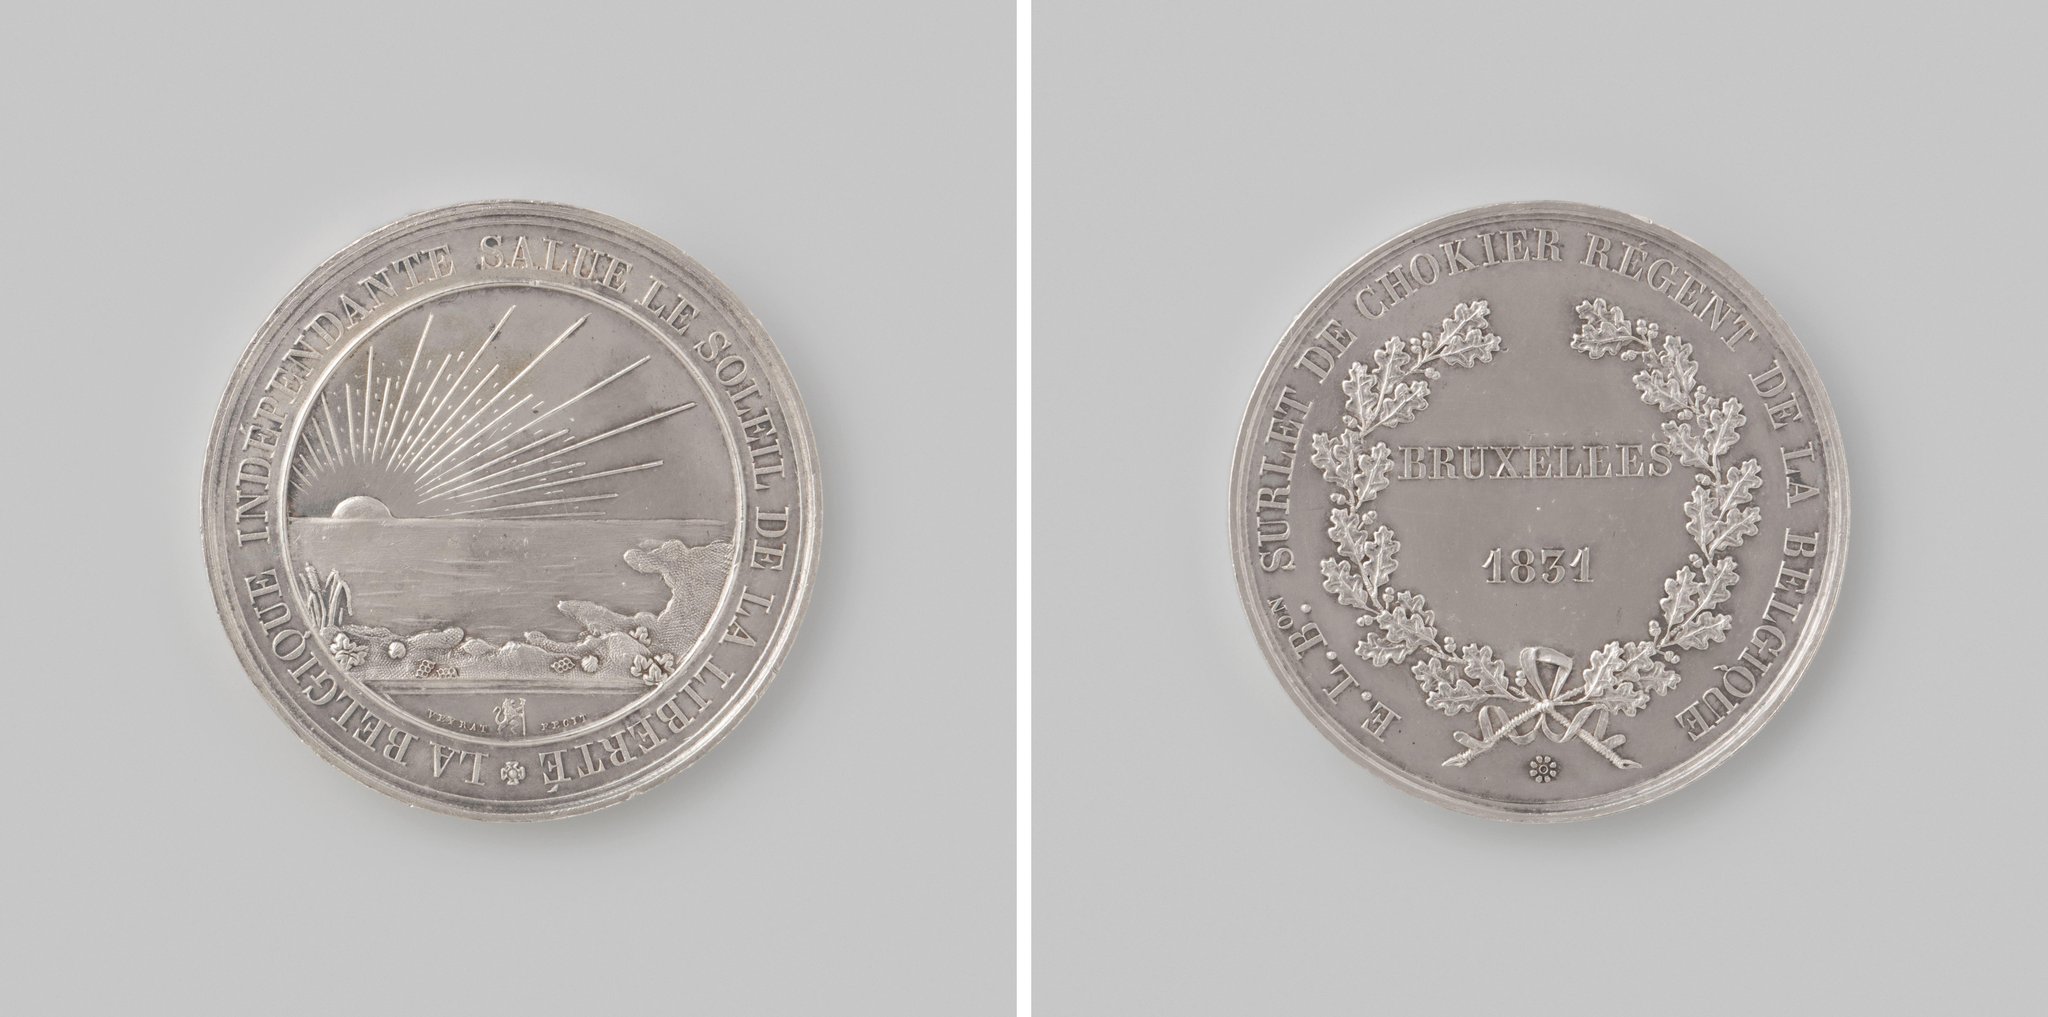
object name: history medal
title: Baron Surlet de Chokier, door het Nationaal Congres verkozen tot regent van België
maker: adrien hippolyte veyrat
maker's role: medailleur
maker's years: 1803-1883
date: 1831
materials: silver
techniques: striking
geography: brussels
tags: brussels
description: Zilveren penning. Voorzijde: opkomende zon beschijnt Belgische kust binnen omschrift; afsnede: signatuur onderbroken door leeuwtje met vrijheidsstaf. Keerzijde: opschrift binnen eikenkrans en omschrift.